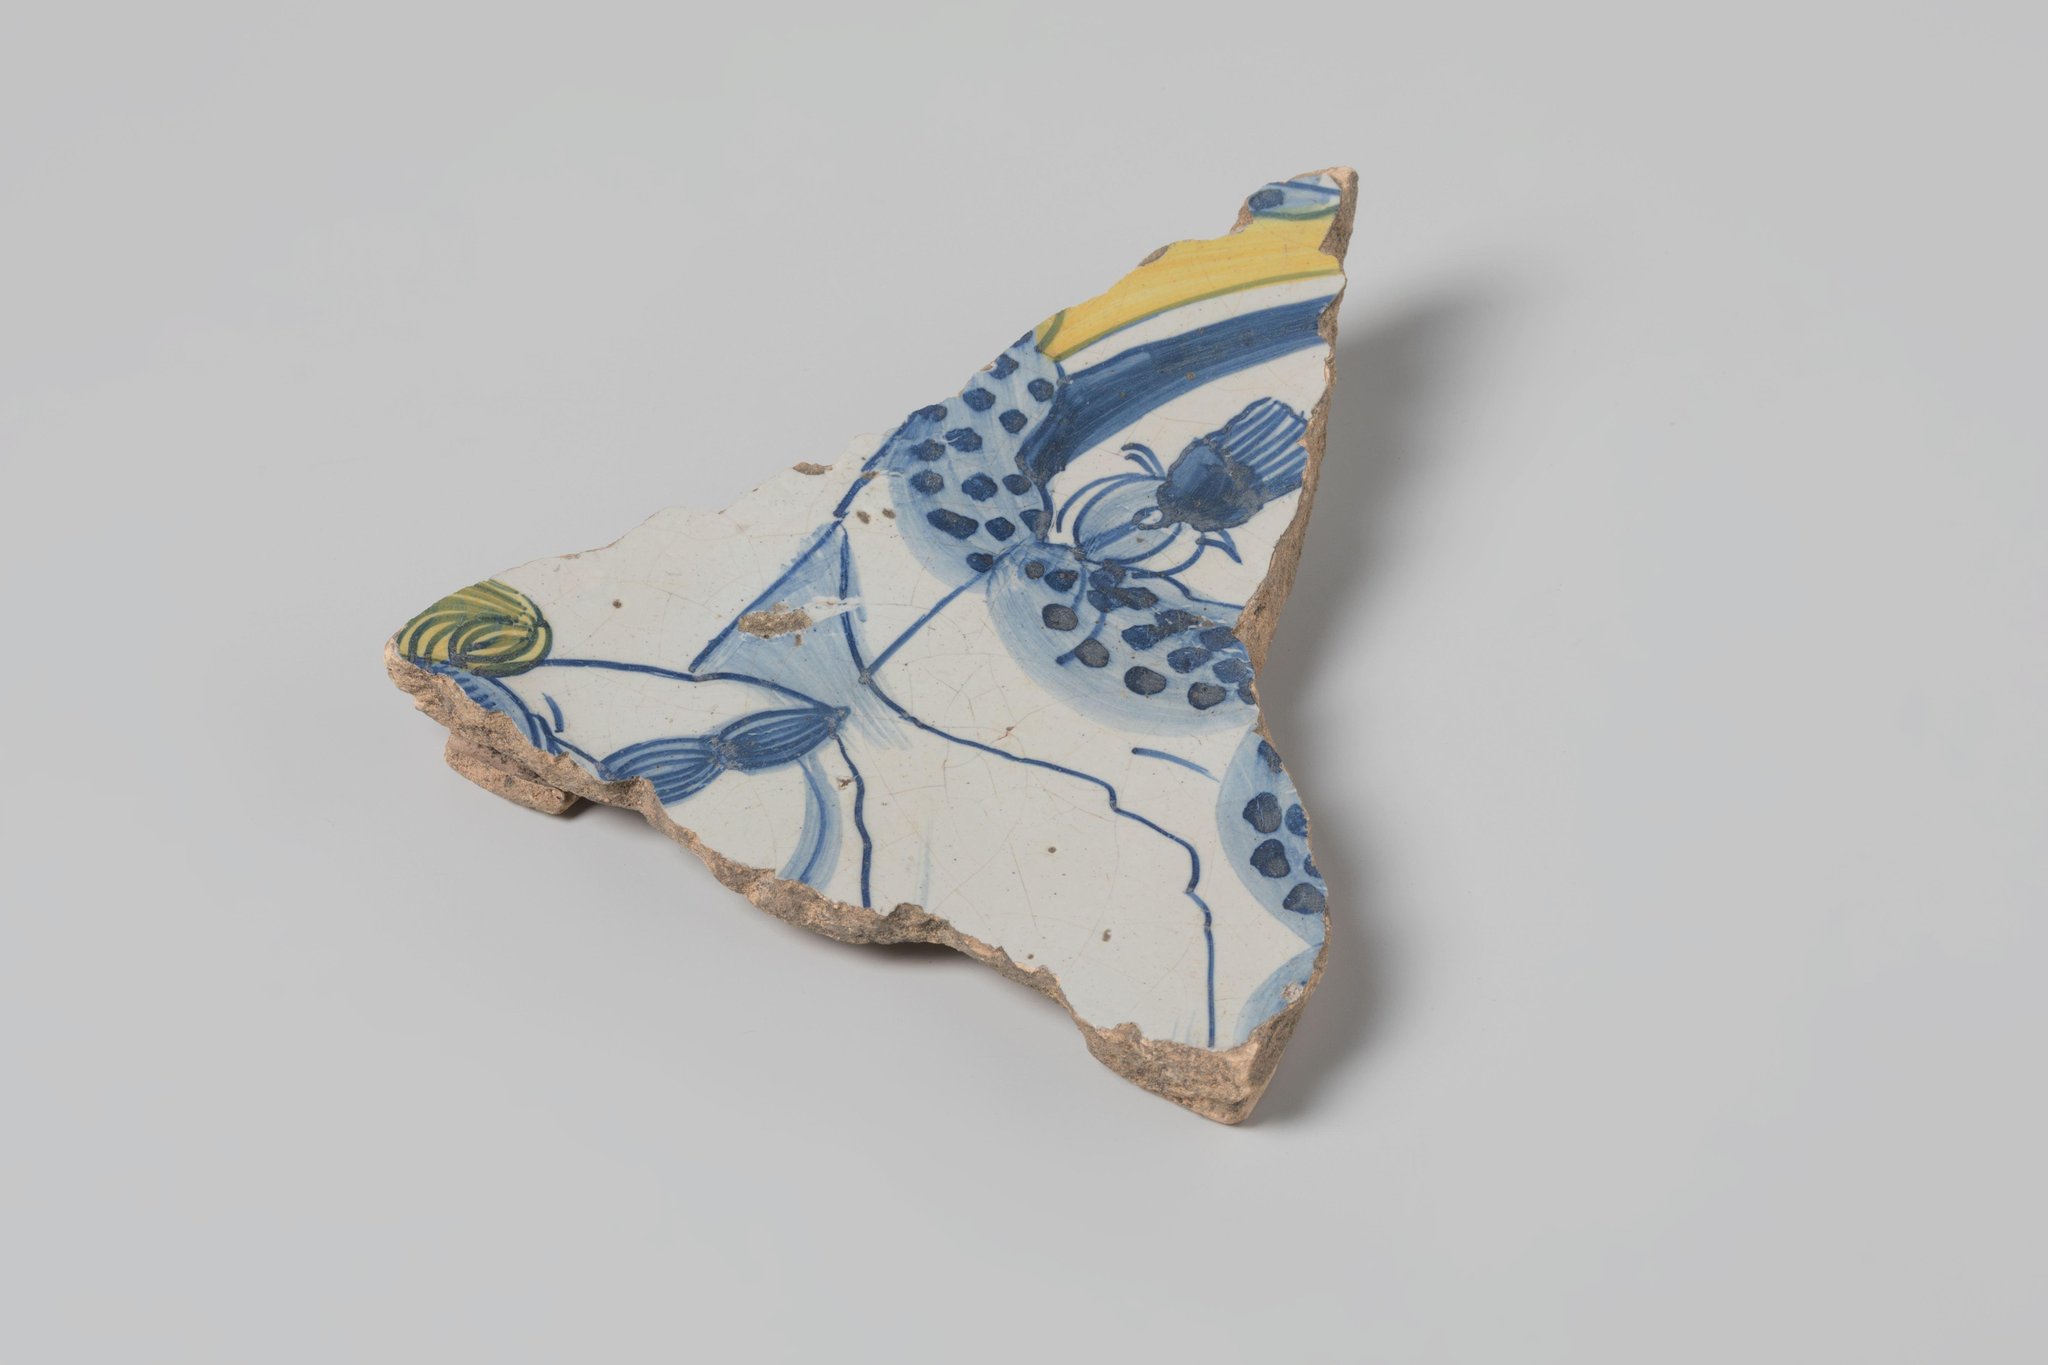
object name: sherd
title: Schotelscherf van aardewerk met aan de achterzijde loodglazuur en aan de voorzijde tinglazuur en een deel van een portret in blauw en geel, beschadigd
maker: Anonymous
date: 1500-1799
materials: earthenware, glaze